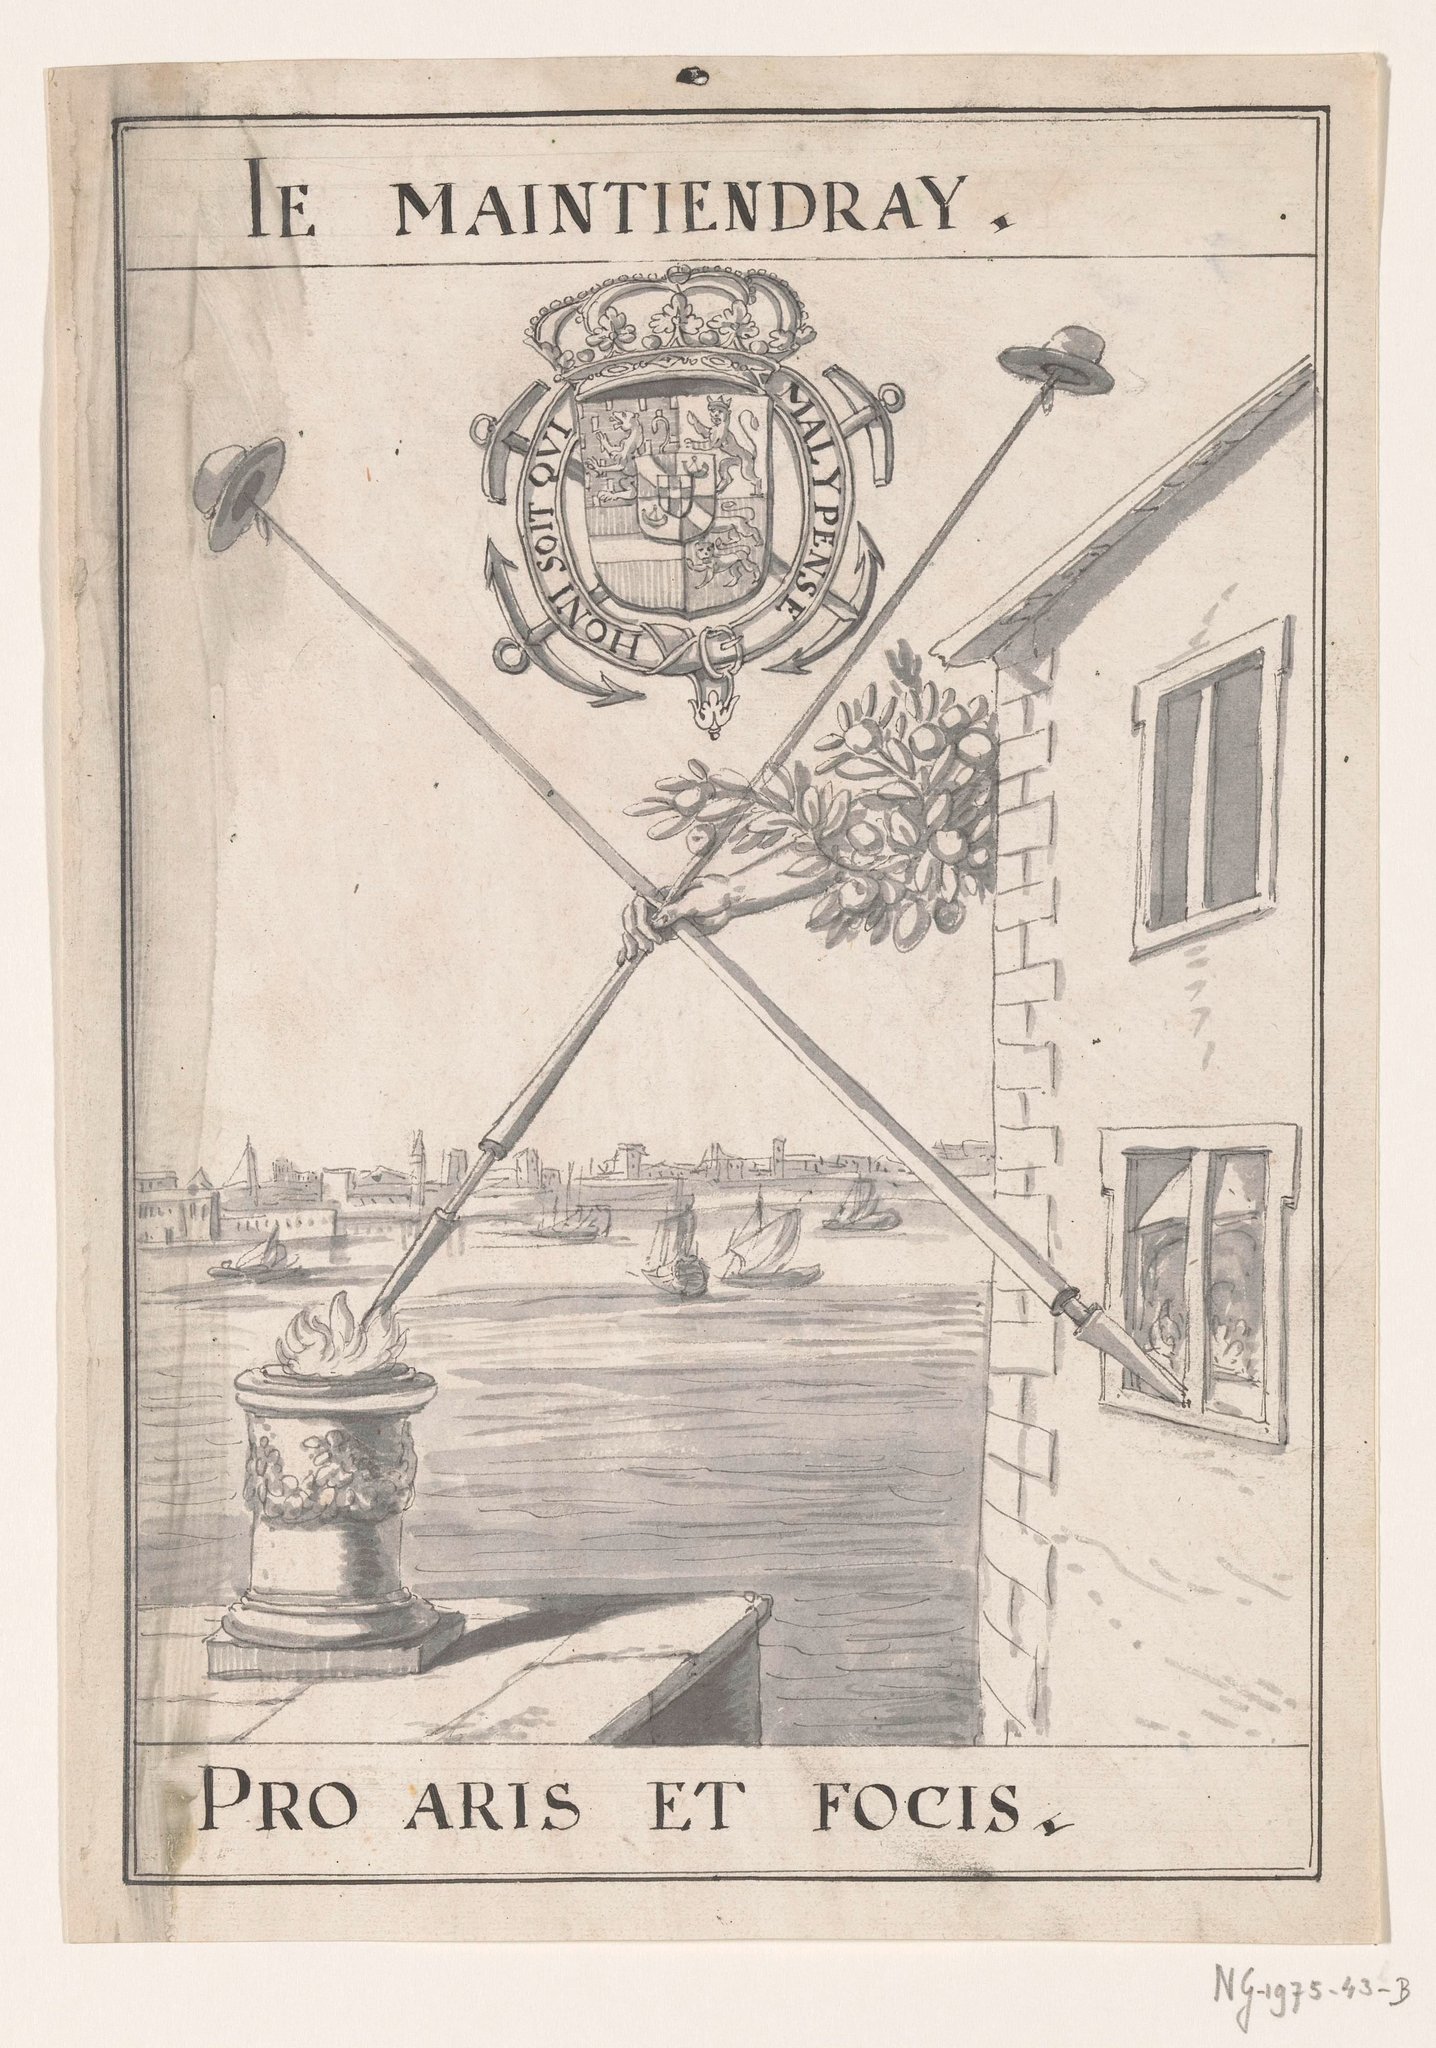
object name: drawing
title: Allegorisch embleem bij de Vrede van Rijswijk, 1697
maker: Anonymous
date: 1697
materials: ink, paper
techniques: brush, pen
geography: northern netherlands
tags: the hague, william iii (prince of orange and king of england, scotland, and ireland), festivities on events of national importance (+ festive decoration ~ festive activities)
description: Embleem met twee gekruiste lansen met vrijheidshoeden tussen een brandend altaar en raam van gebouw. Op de achtergrond een riviergezicht. Boven het wapen van Willem III met spreuk: Honi soit qui mal y pense. Opschrift: Ie maintiendray / Pro aris et focis. Op de achterkant een kindertekening van een man met hoed. Ontwerp voor een decoratie bij de viering van de Vrede van Rijswijk in 1697.